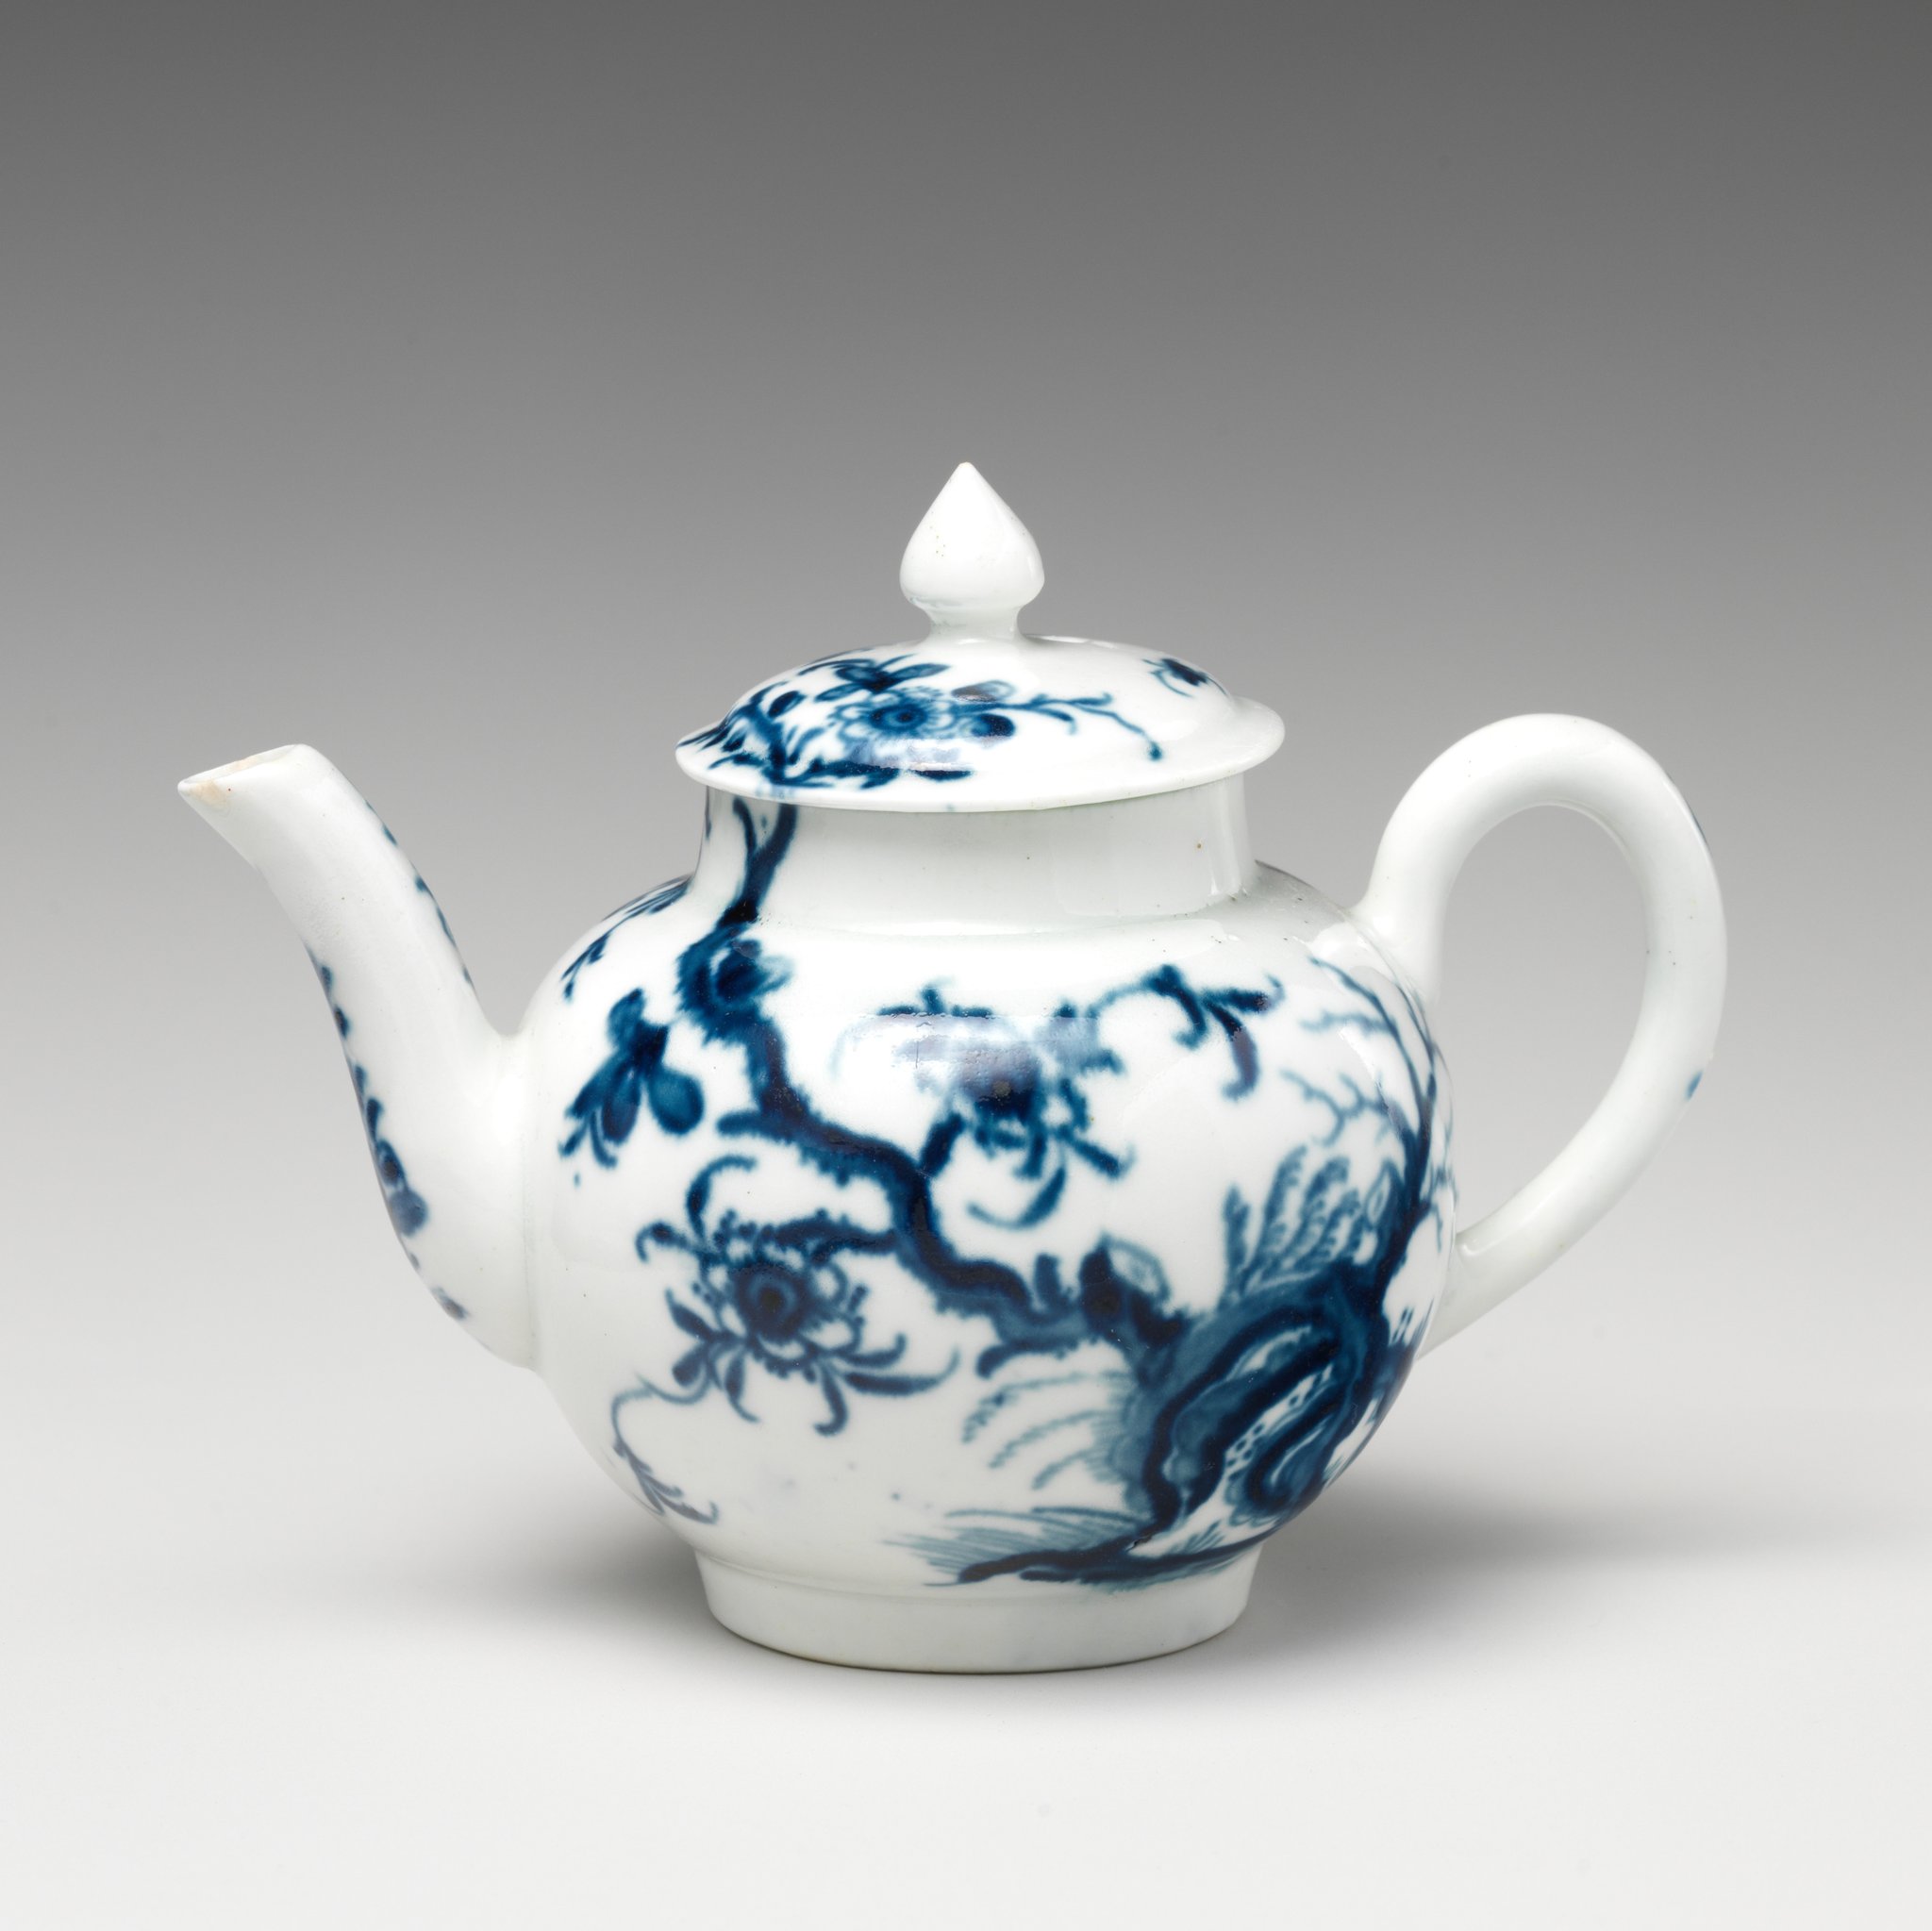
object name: teapot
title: Miniature teapot (part of a service)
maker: worcester factory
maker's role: factory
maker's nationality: british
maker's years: 1751-2008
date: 1760-1762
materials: soft paste porcelain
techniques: underglaze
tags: flowers